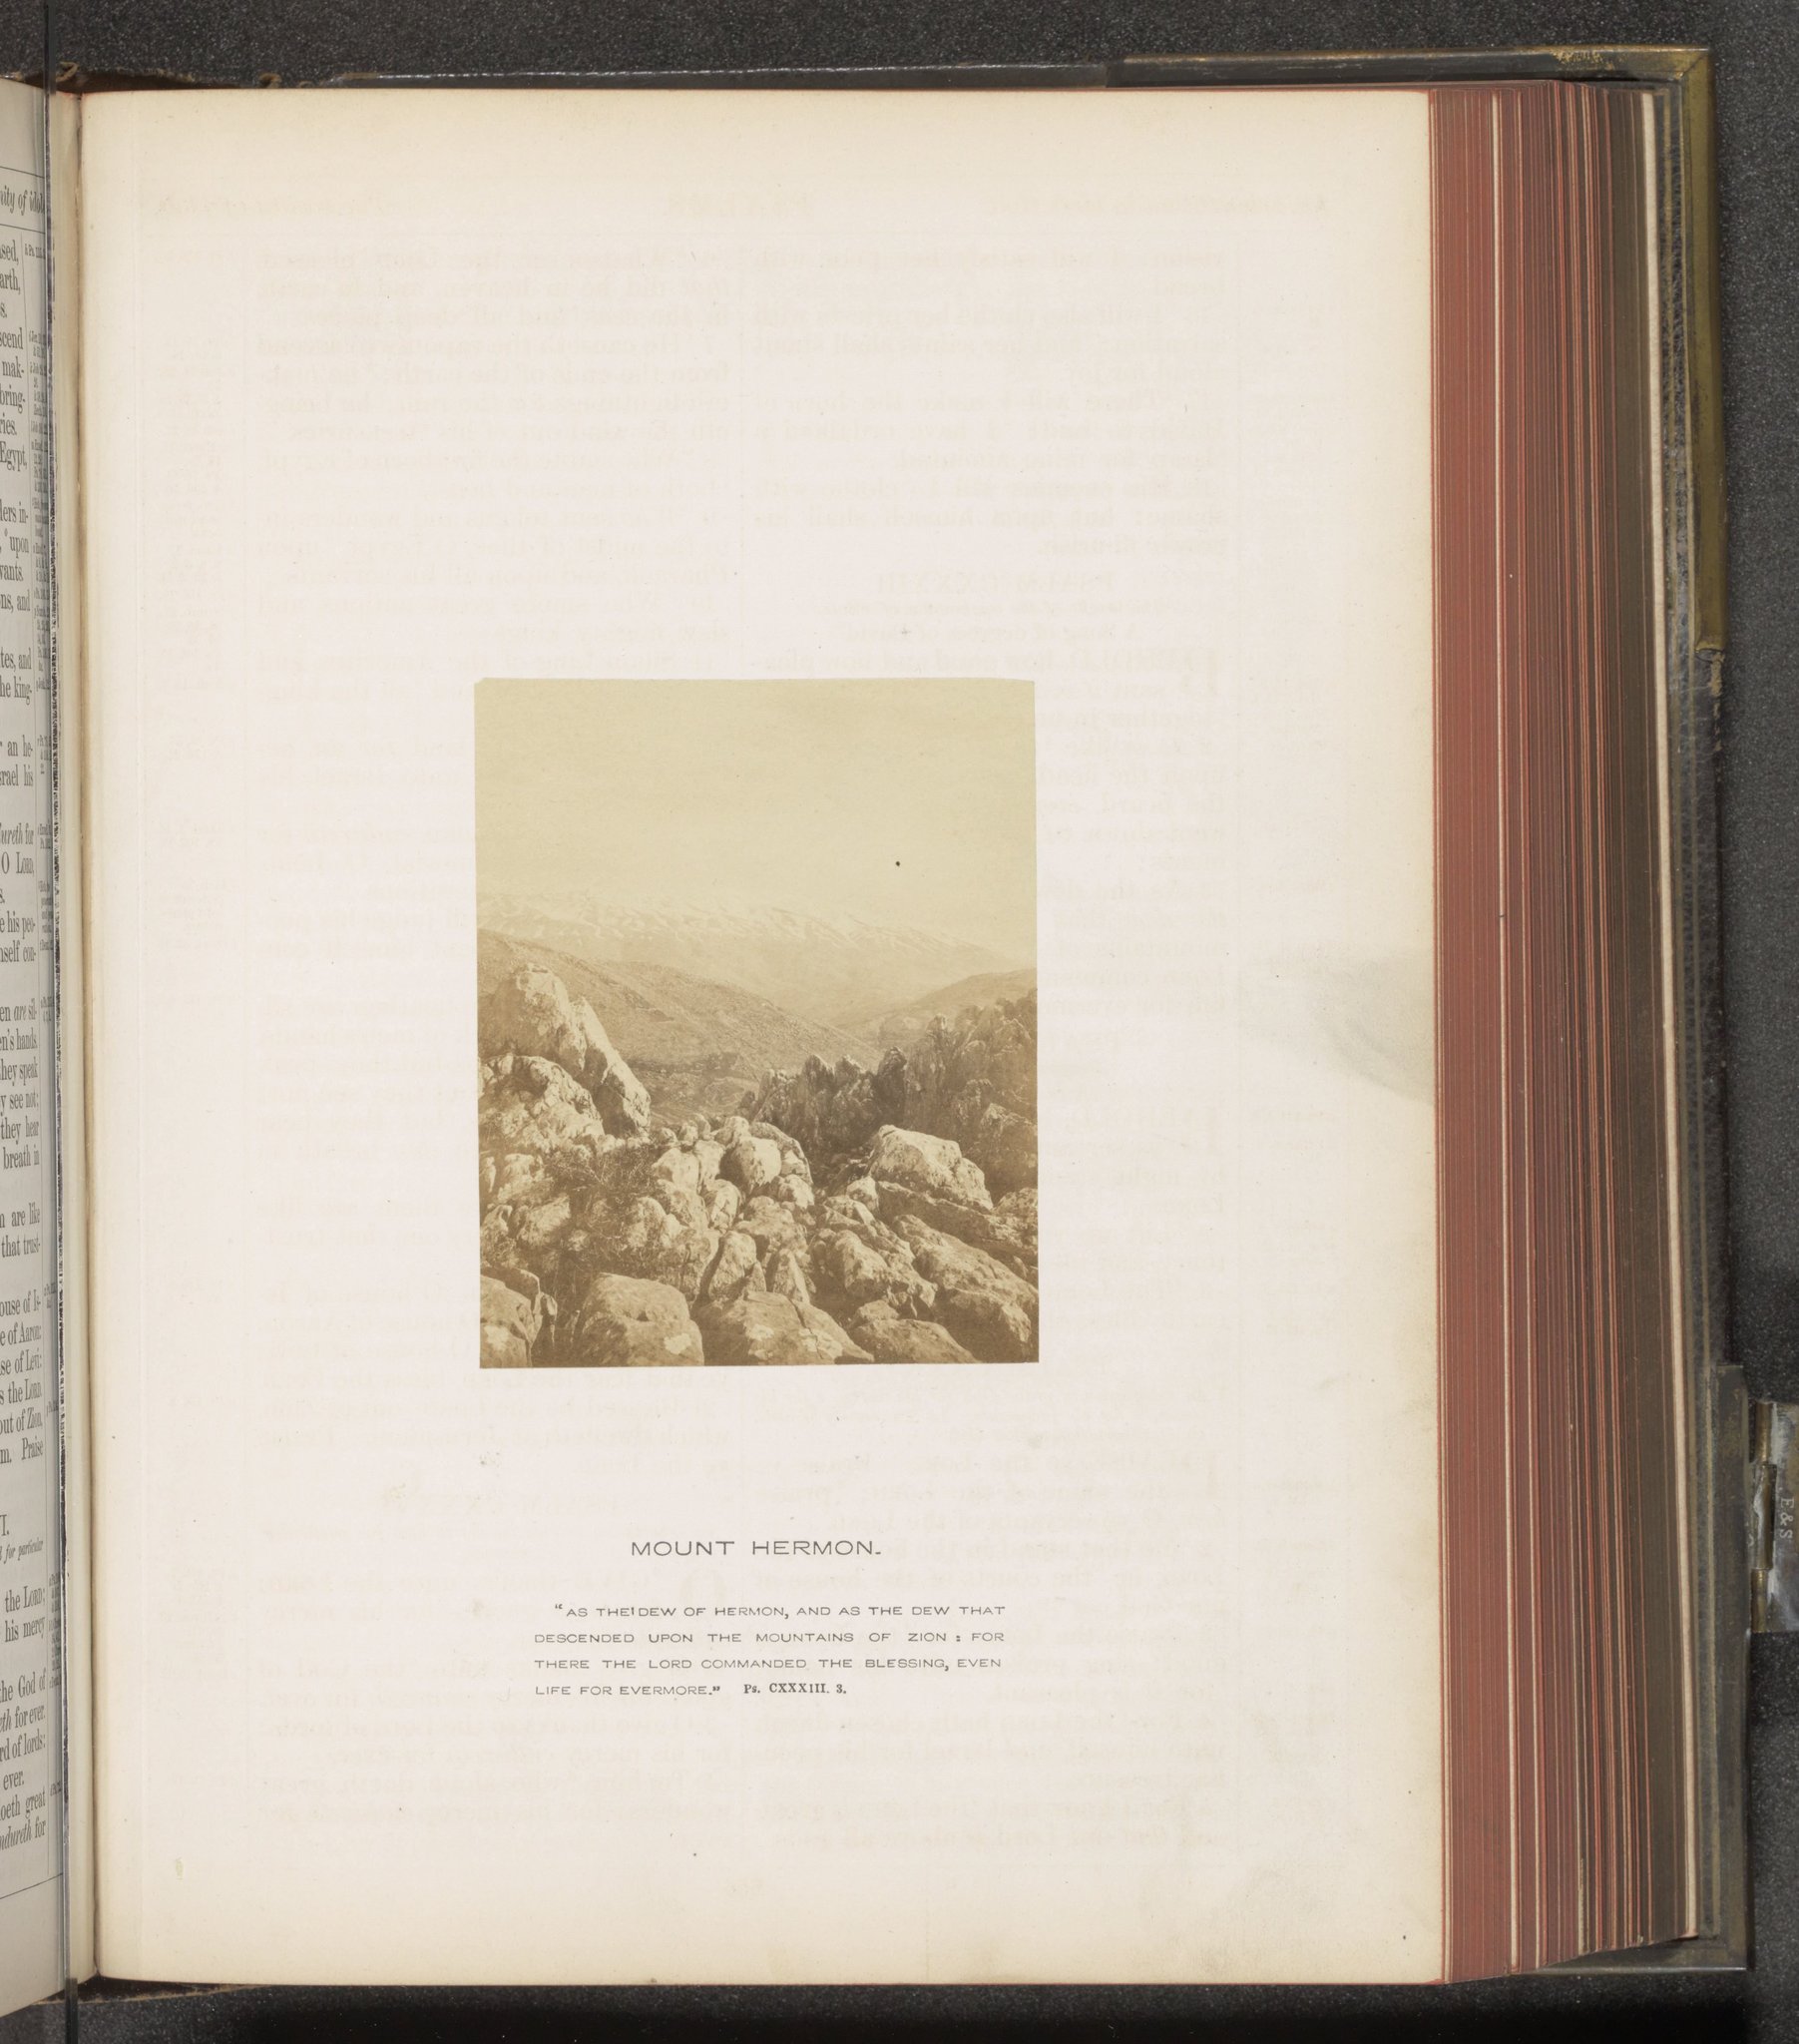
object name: page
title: Gezicht op de Hermonberg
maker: francis frith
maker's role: publisher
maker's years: 1822-1898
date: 1850-1865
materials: photographic support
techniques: albumen print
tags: mountains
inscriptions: inscription: ‘"As thei dew of Hermon, and as the dew that descended upon the mountains of zion: for there the lord commanded the blessing, even life for evermore."Ps. CXXXIII. 3.’